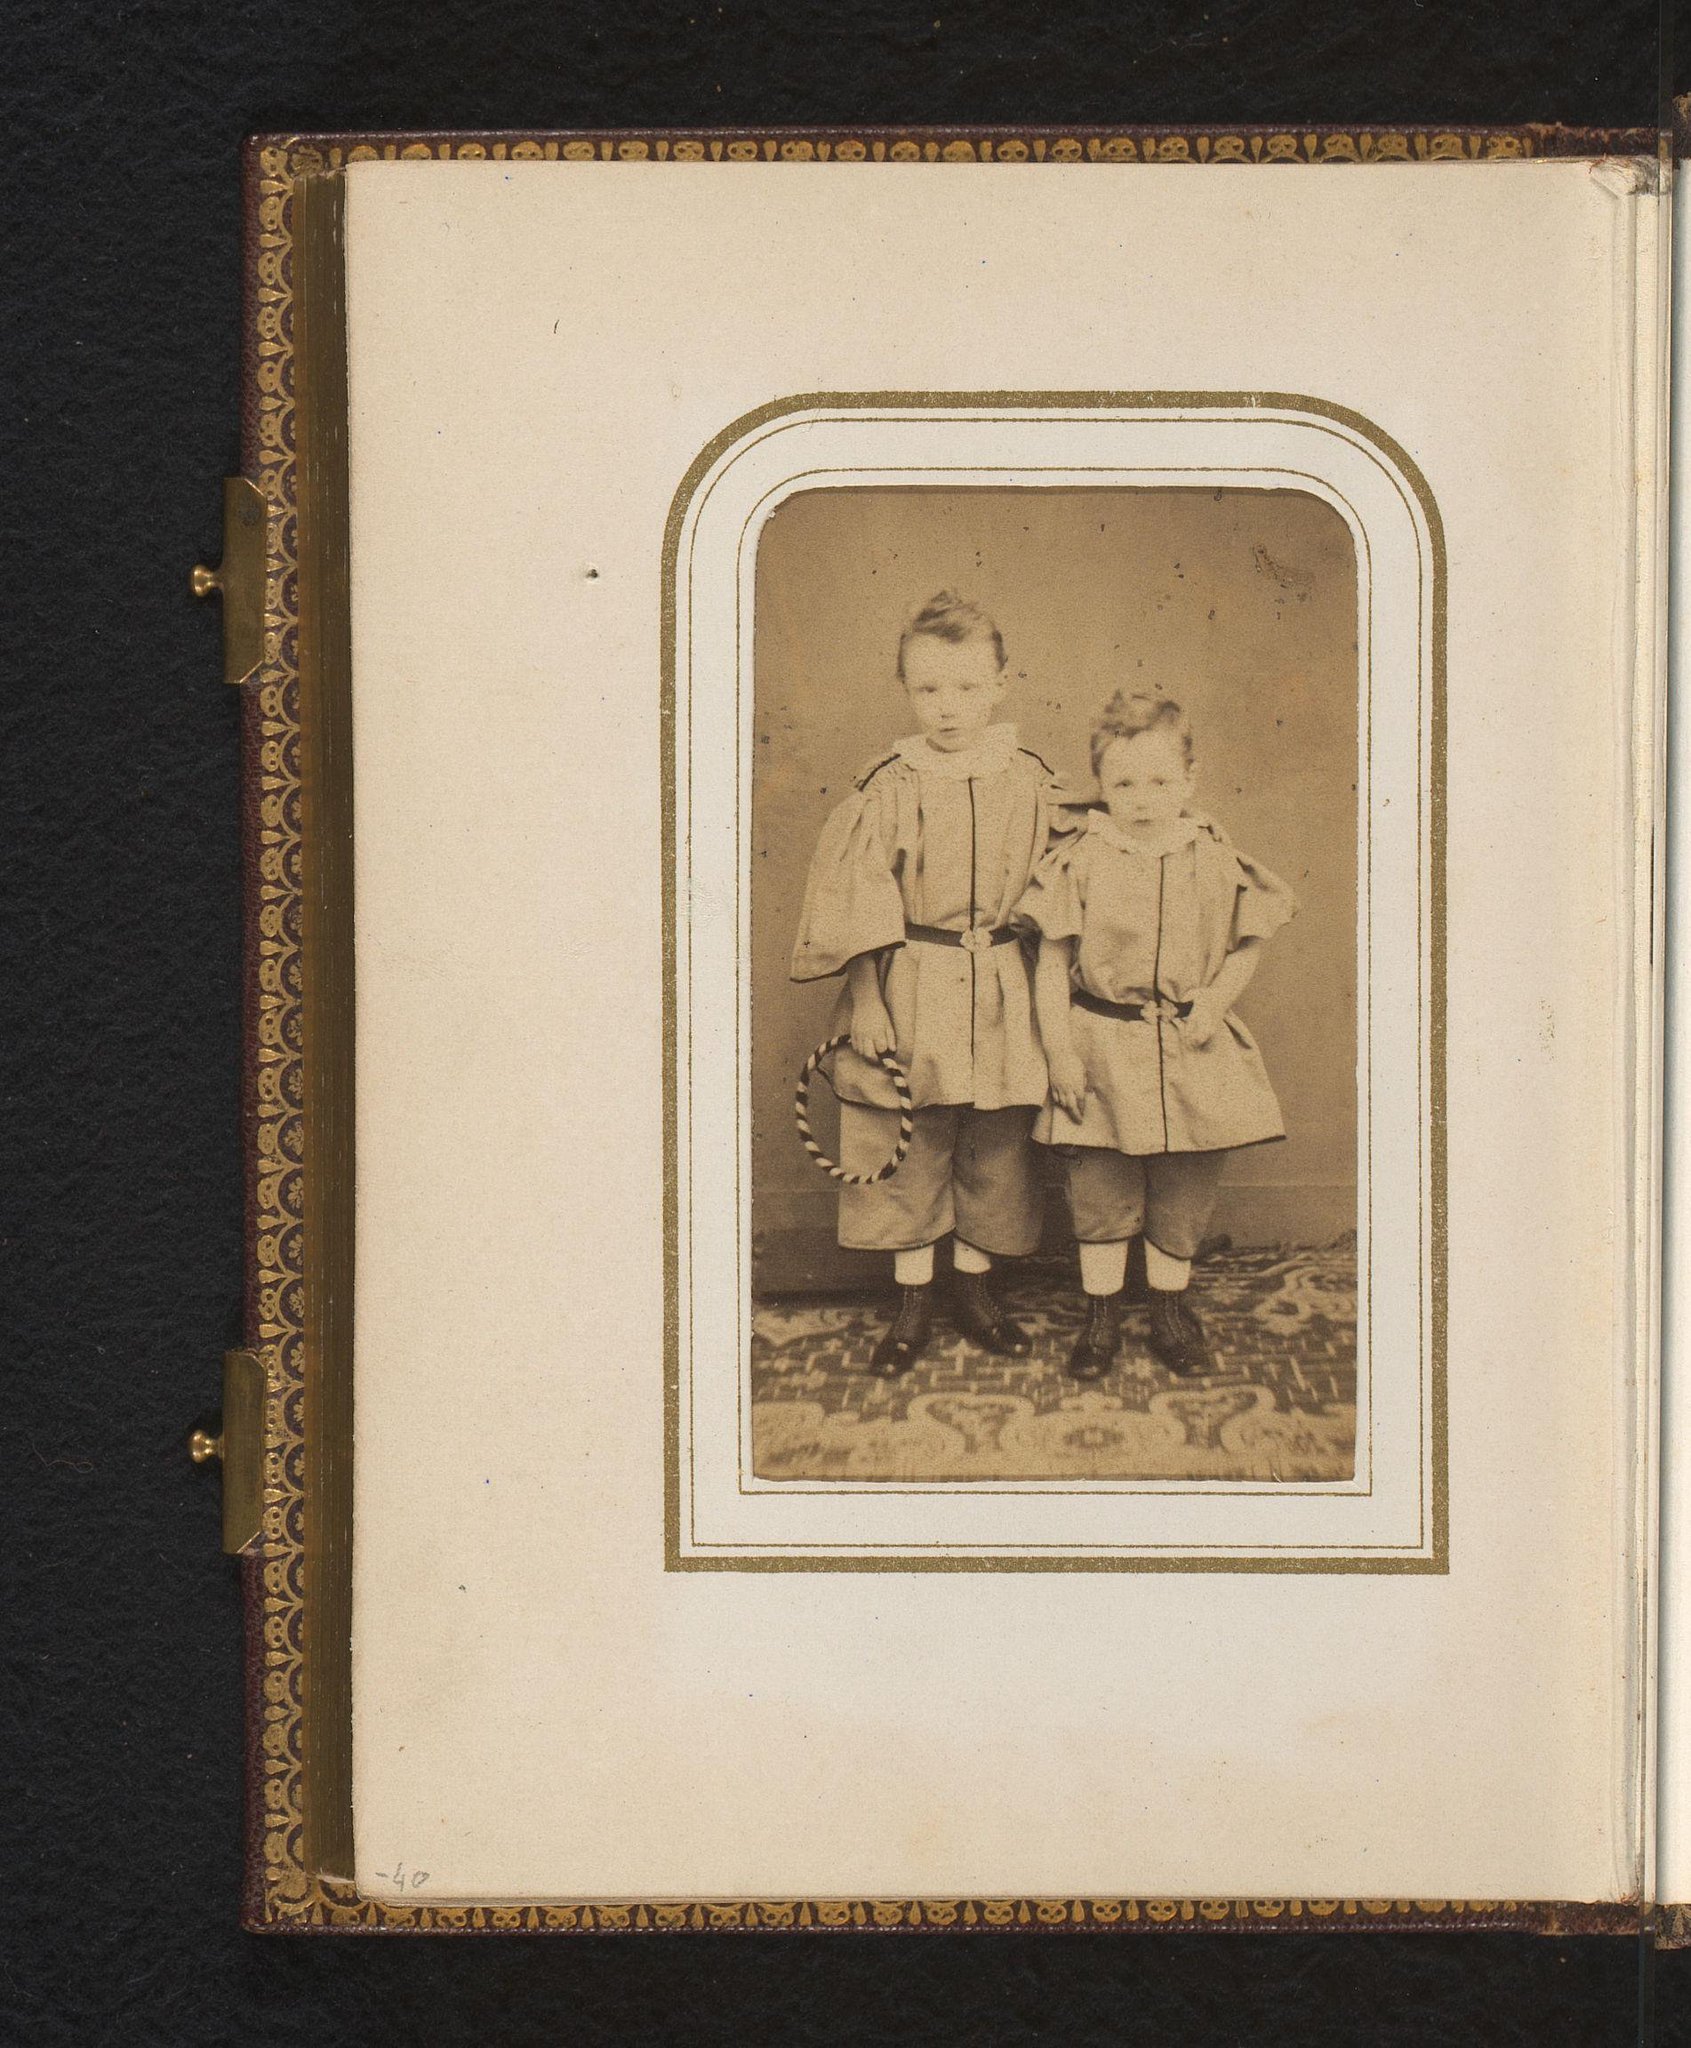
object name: photograph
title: Portret van twee onbekende kinderen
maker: Anonymous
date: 1860-1870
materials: cardboard, paper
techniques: albumen print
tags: child, anonymous historical person portrayed